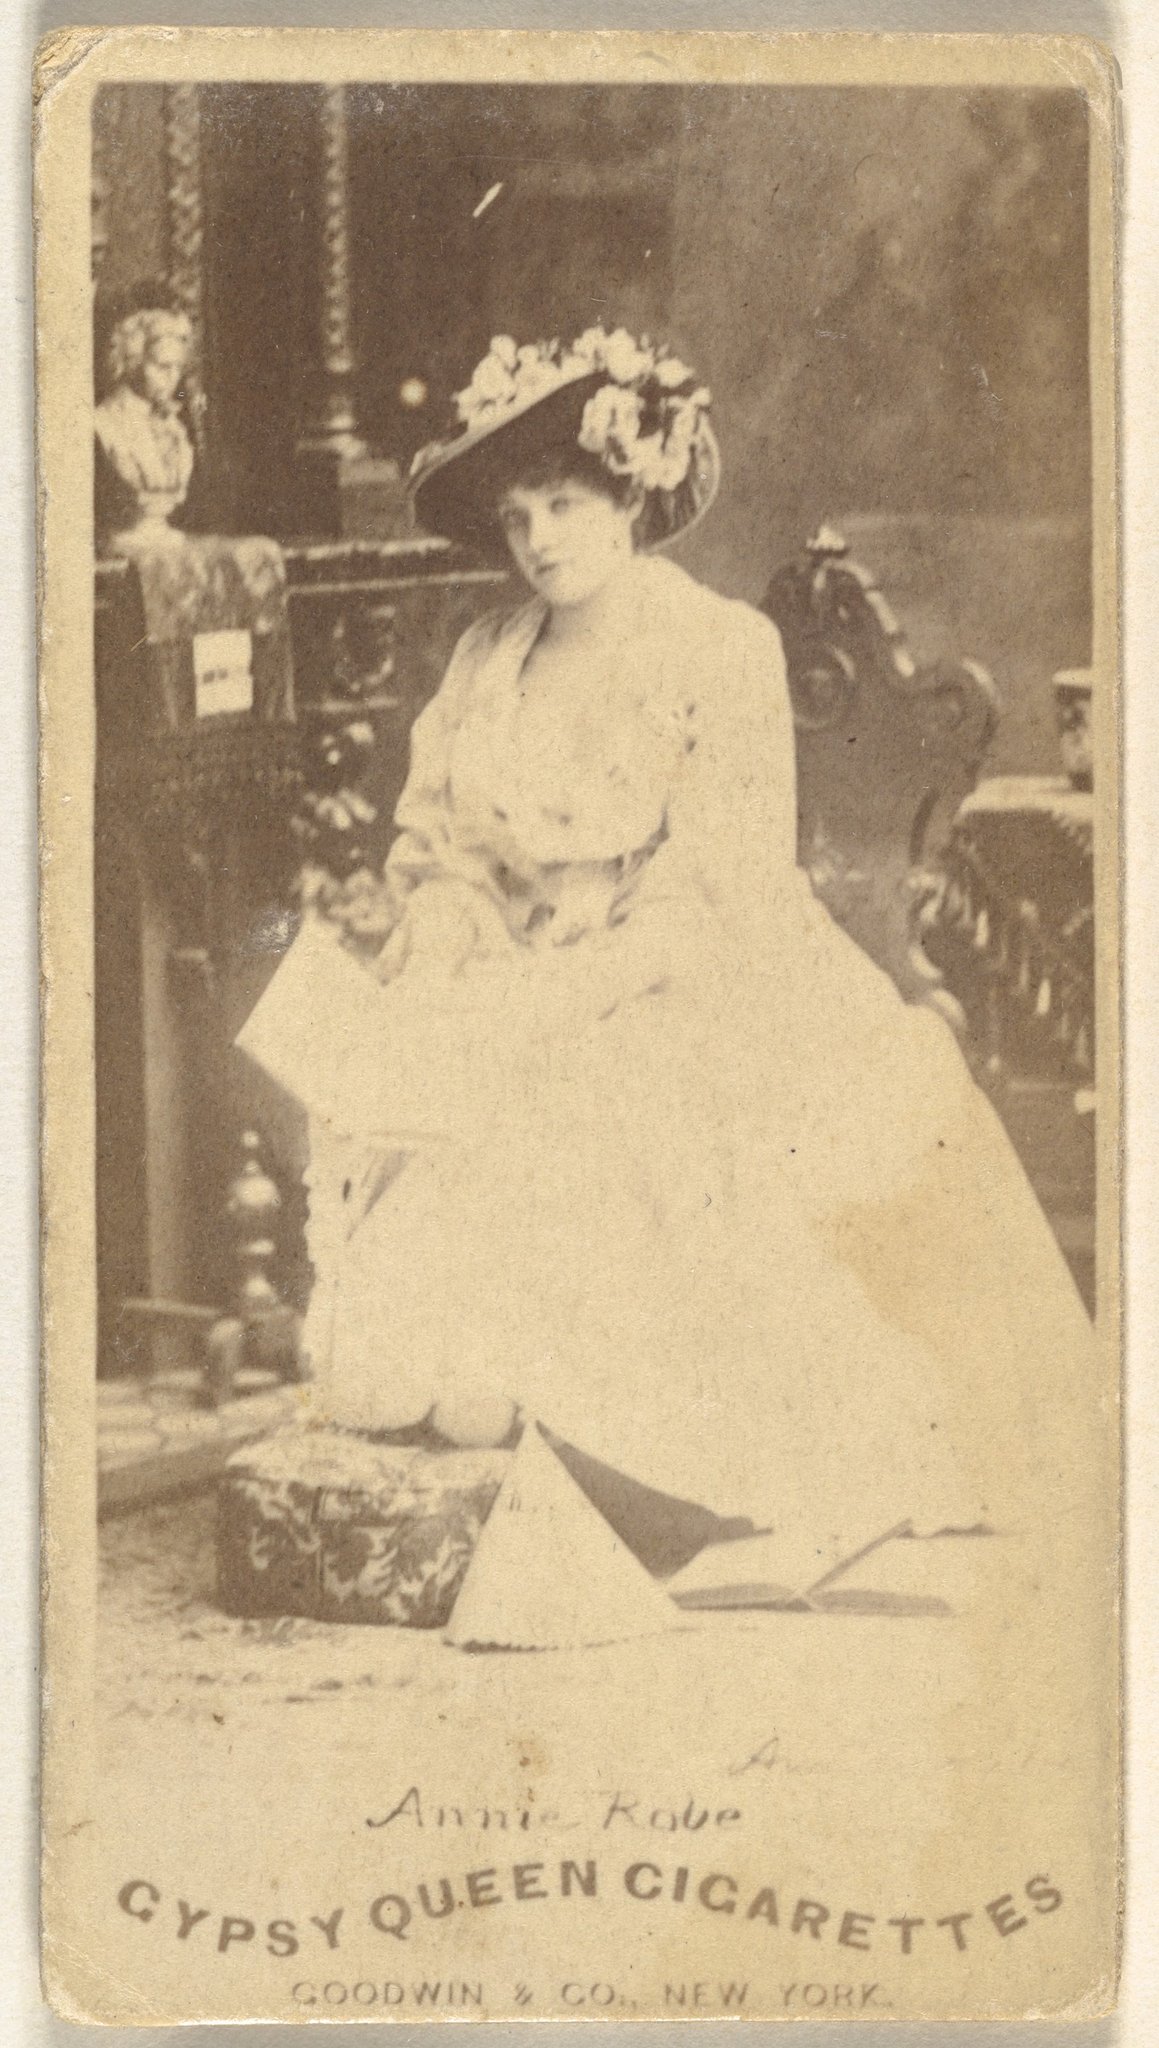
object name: photograph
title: Annie Robe, from the Actors and Actresses series (N171) for Gypsy Queen Cigarettes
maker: goodwin & company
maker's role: publisher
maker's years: 1850-1950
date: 1886-1890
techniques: albumen silver print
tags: portraits,women,actresses